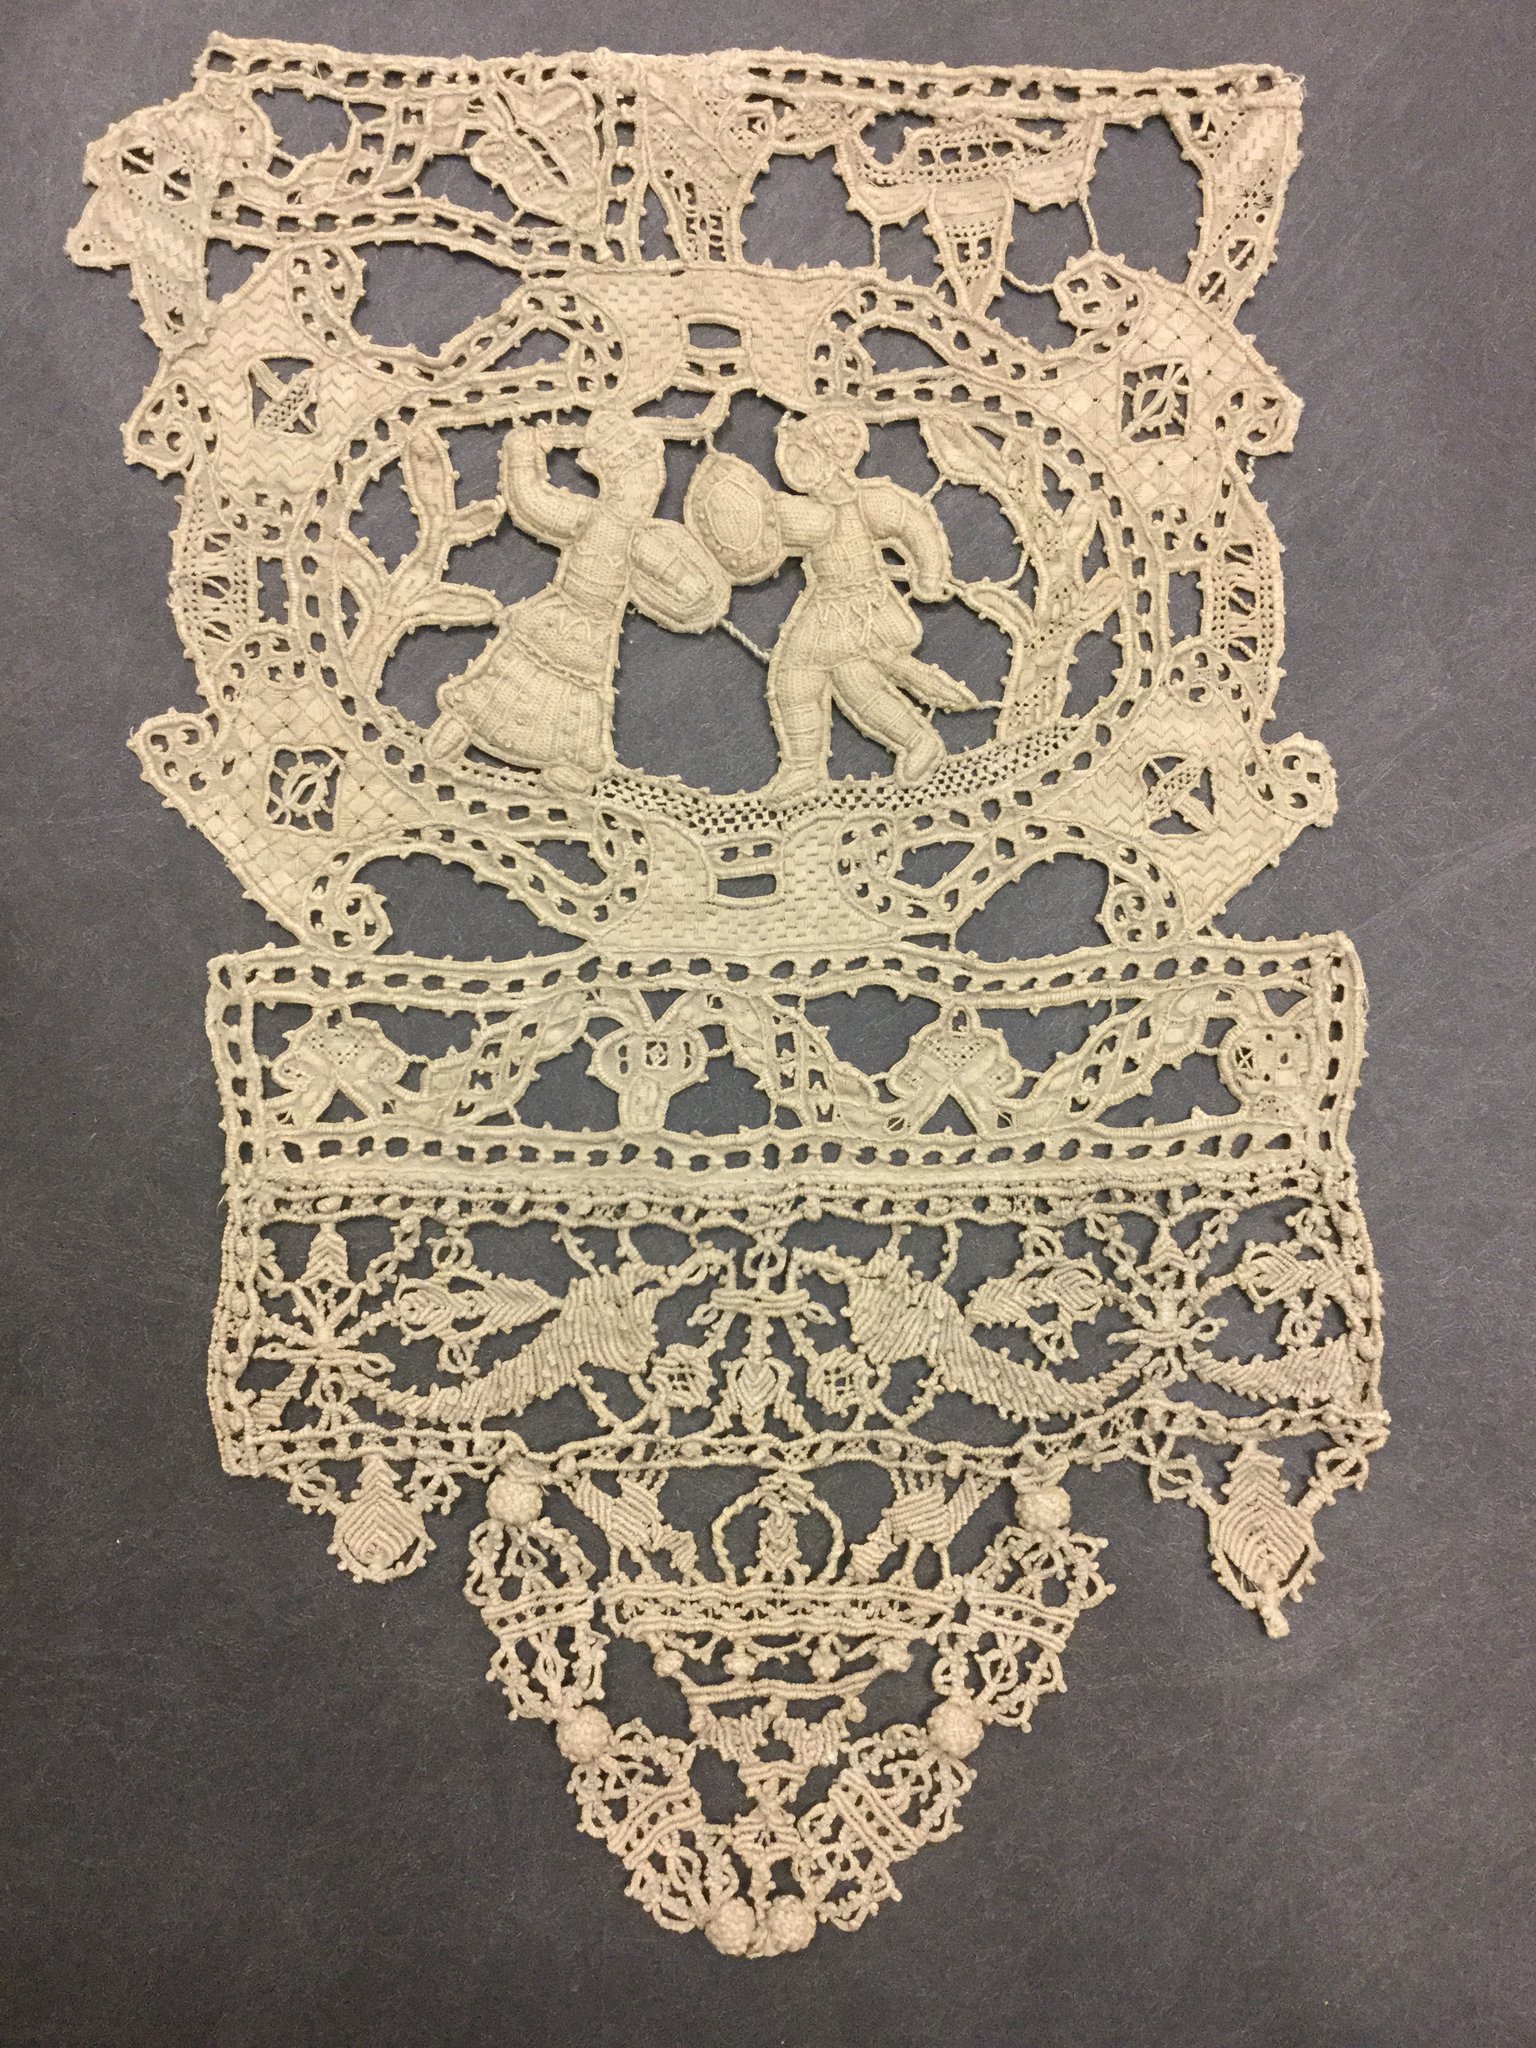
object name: piece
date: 1601-1700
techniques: embroidery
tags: human figures